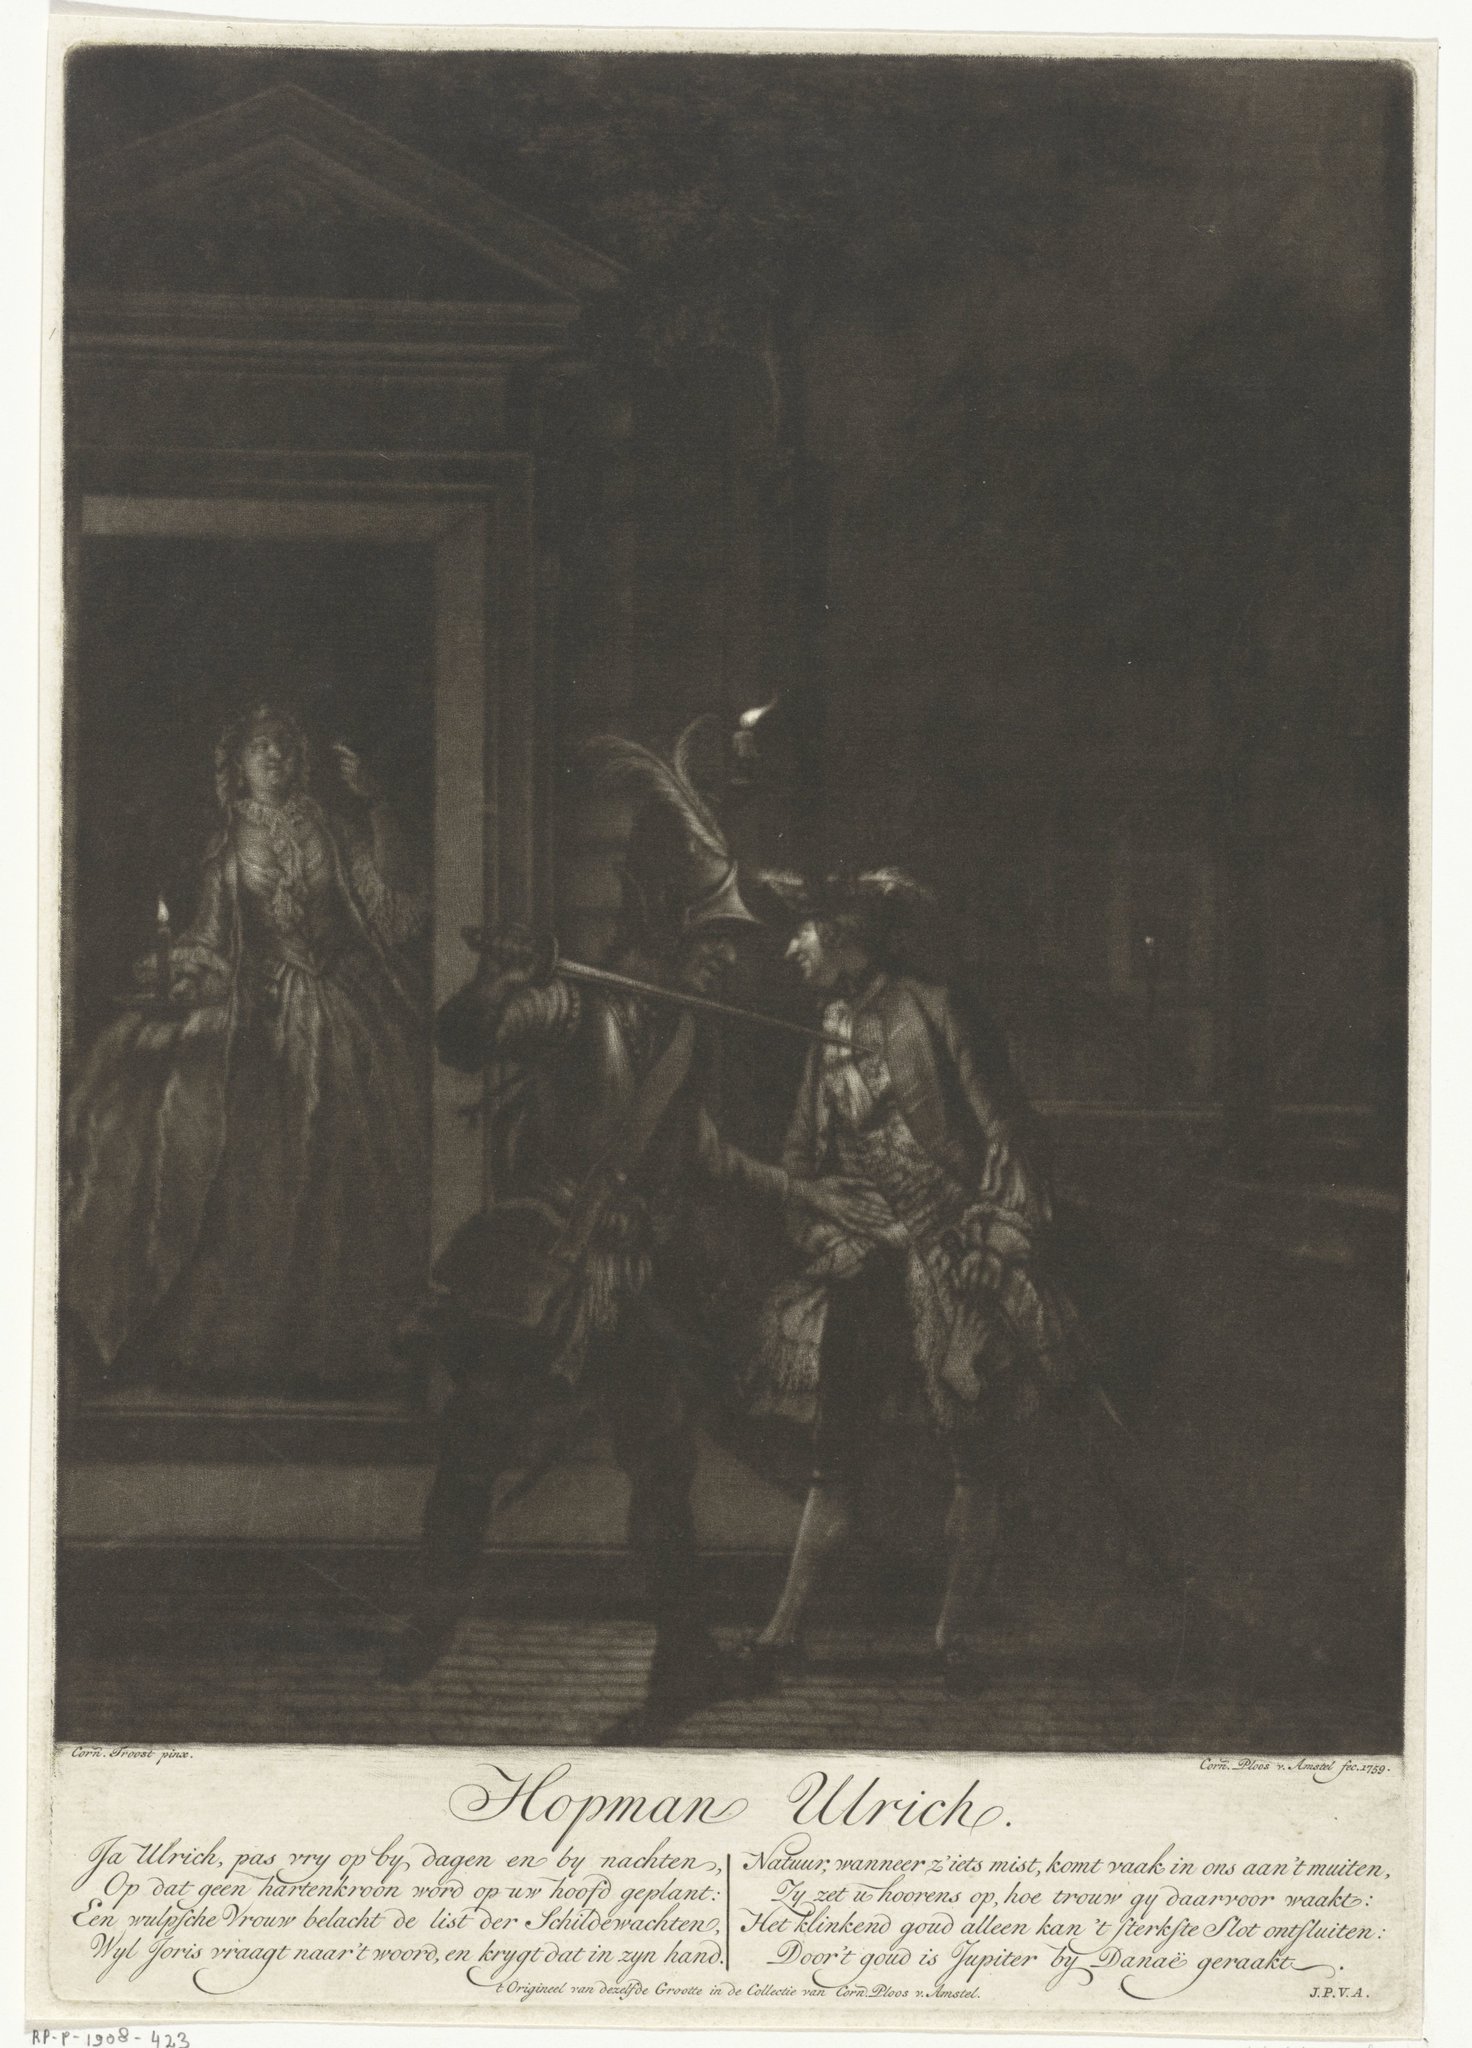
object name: print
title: Hopman Ulrich of de bedrogen gierigheid: de omkoping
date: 1759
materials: paper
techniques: engraving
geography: amsterdam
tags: comedy, candlestick, guard duty, keeping sentry, night, bribery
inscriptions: collector's mark: Lugt 2228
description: Een wachter vraagt een jongeman (Godefroy), die heimelijk in de nacht bij zijn geliefde (Sybille) op bezoek komt, om geld. De jongeman steekt zijn hand in zijn broekzak. De omkopingsscène uit het tweede bedrijf van het blijspel 'Hopman Ulrich of de bedrogen gierigheid' van Johan van Paffenrode (1661). In het blijspel wordt het gierige personage Ulrich bedrogen door zijn vrouw Sybille, ondanks dat hij haar laat bewaken. Haar minnaar Godefroy koopt de wachter om.